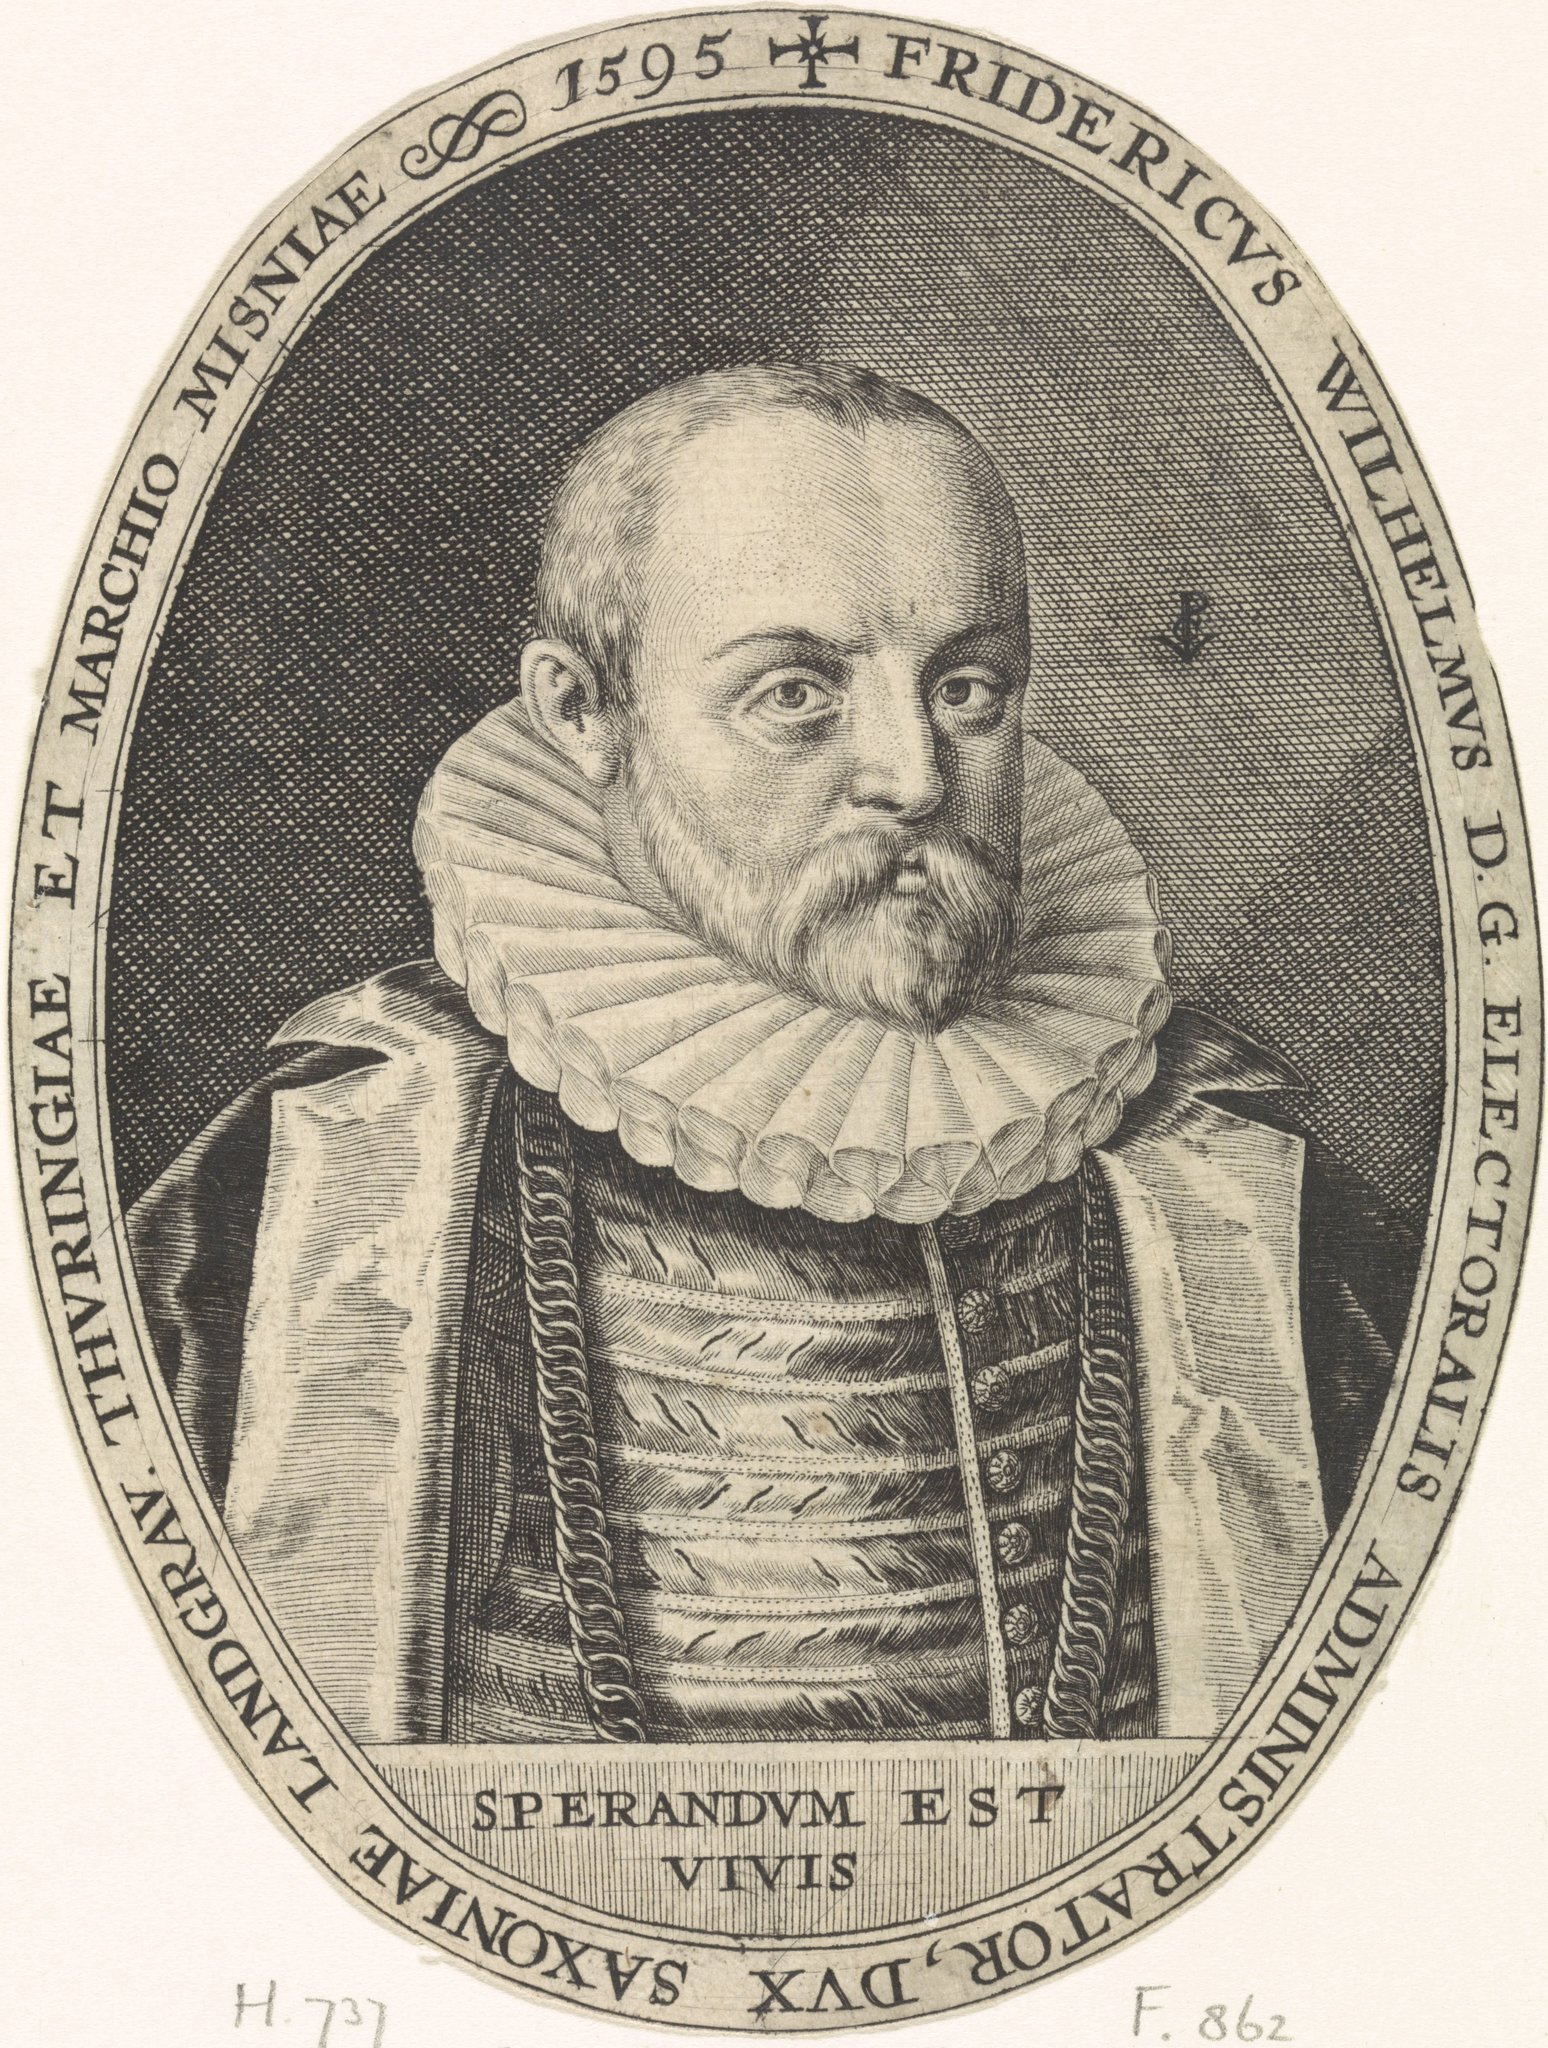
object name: print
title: Portret van Frederik Willem, hertog van Saksen-Weimar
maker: crispijn van de passe (i)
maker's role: draughtsman, print maker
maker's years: 1564-1637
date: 1595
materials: paper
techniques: engraving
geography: cologne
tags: weimar, hertog, frederik willem i (hertog van saksen-weimar)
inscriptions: collector's mark: Lugt 2228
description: Portret van Frederik Willem, hertog van Saksen-Weimar, eronder zijn devies in het Latijn.